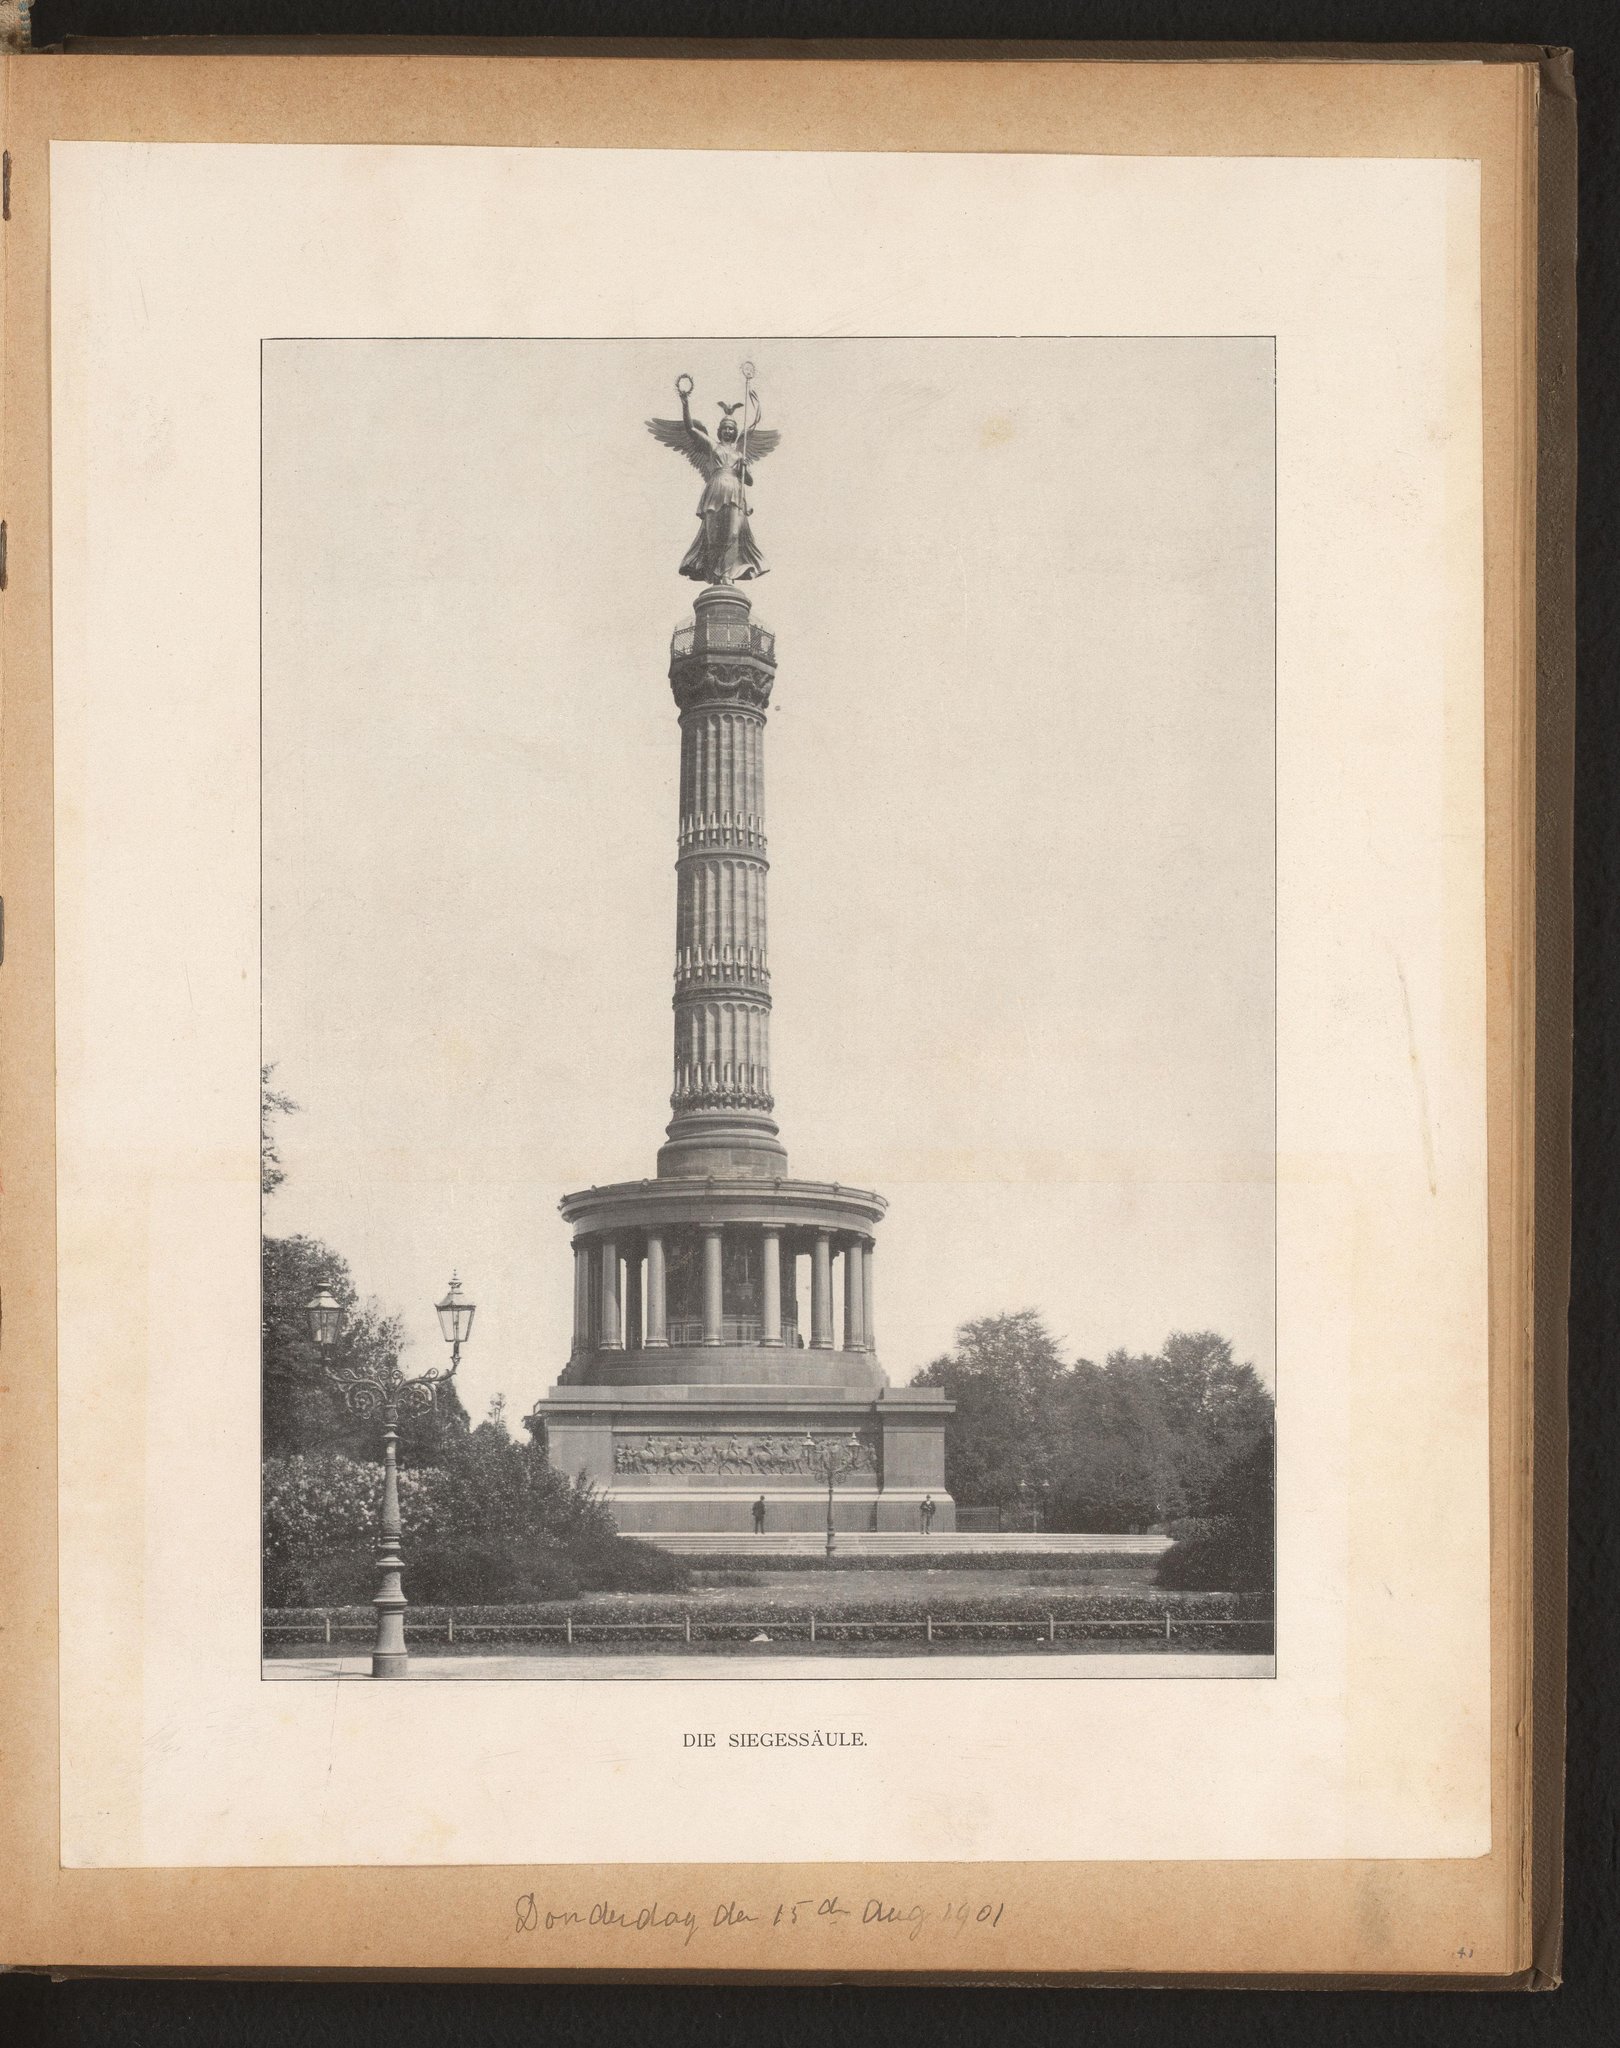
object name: photomechanical print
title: Siegessäule, Berlijn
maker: Anonymous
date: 1896-1901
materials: paper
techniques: autotype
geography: berlin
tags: column, pillar ~ architecture, monument, statue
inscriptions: inscription: ‘Donderdag den 15de Aug 1901’, title: ‘Die Siegessäule.’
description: Deze fotomechanische afdruk maakt deel uit van een album.